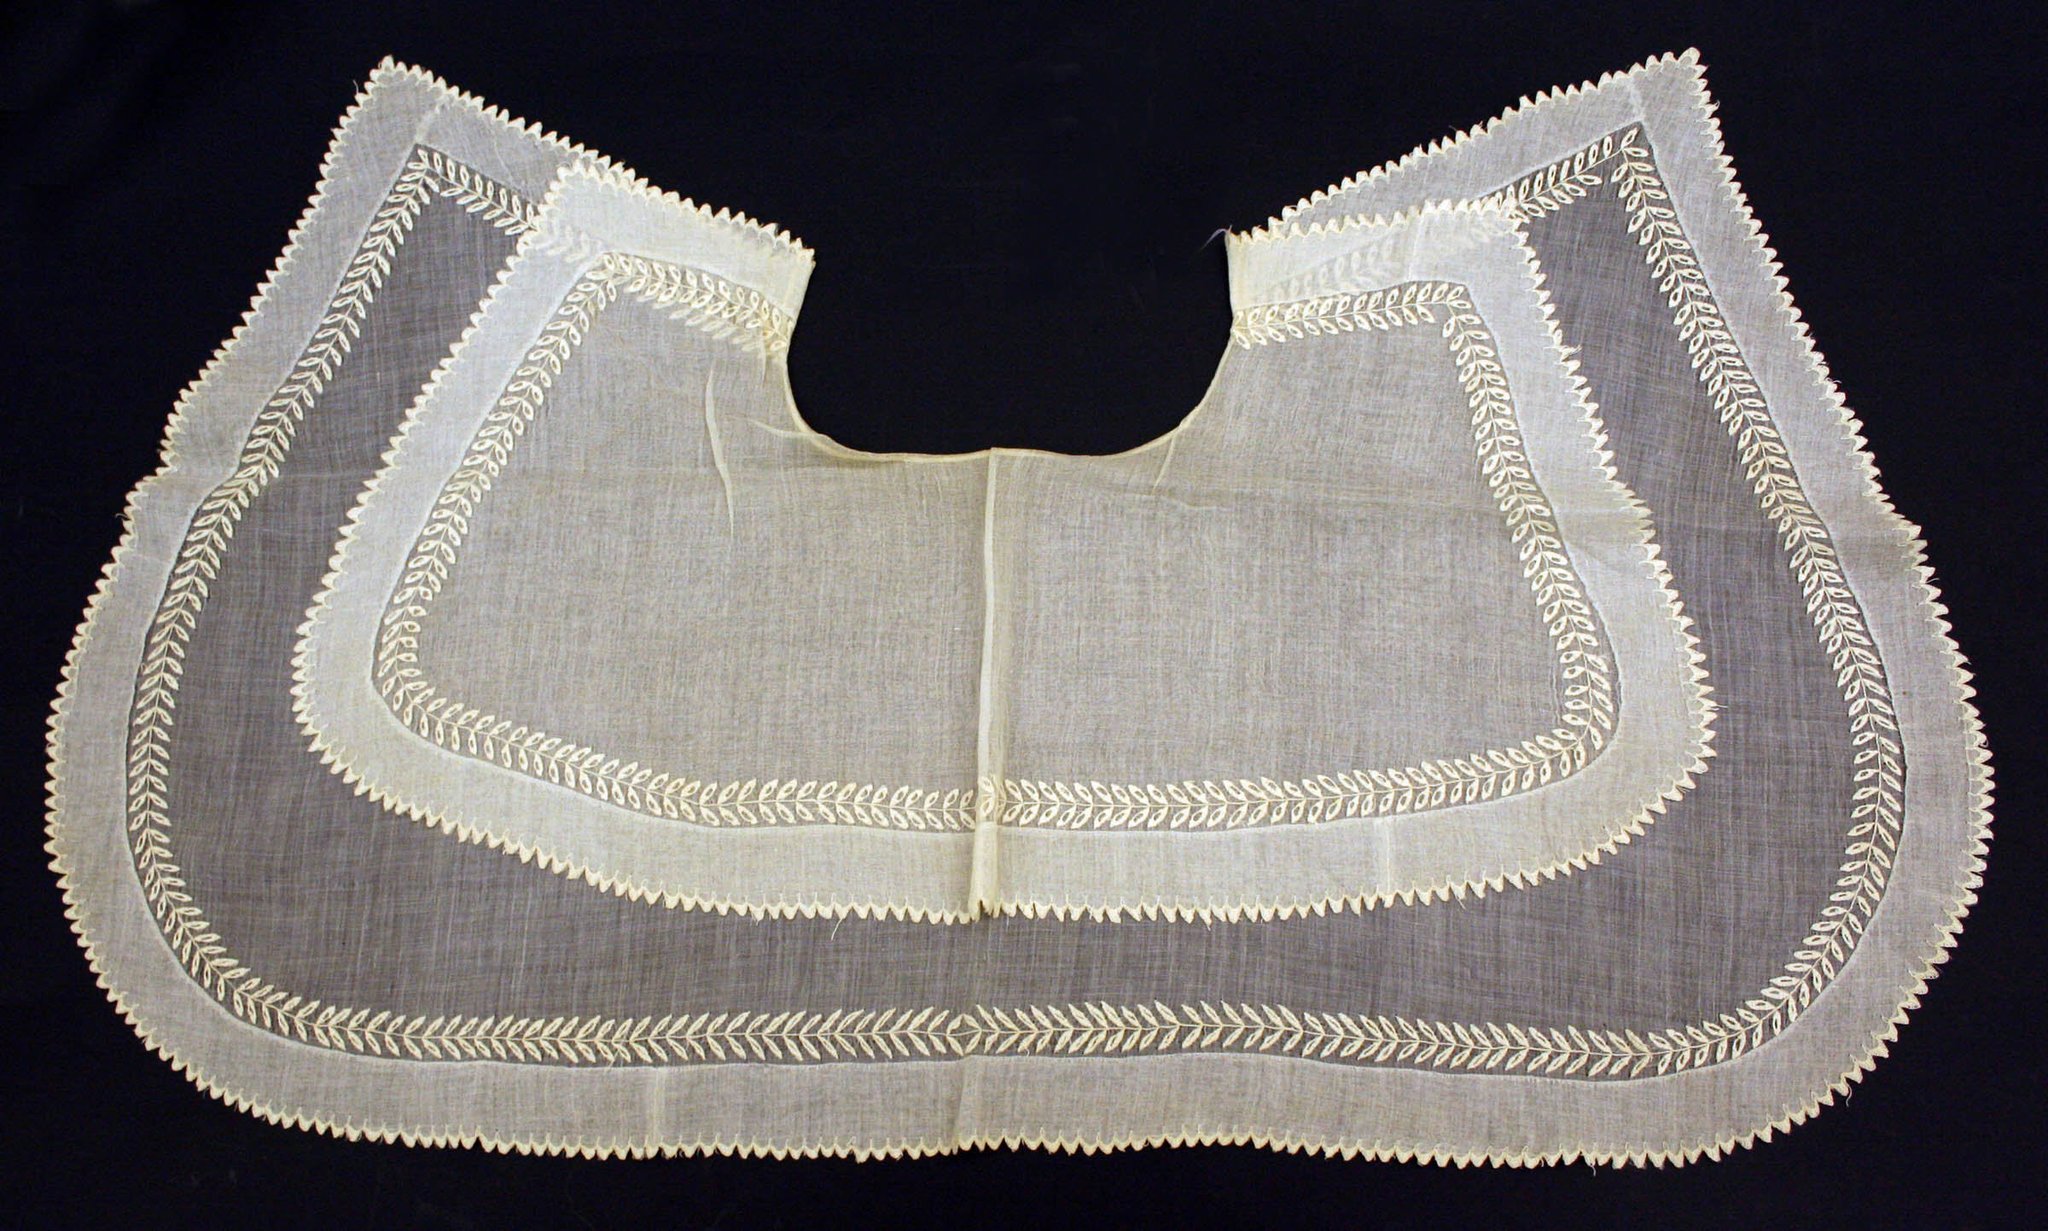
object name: double collar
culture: american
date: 1835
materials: cotton